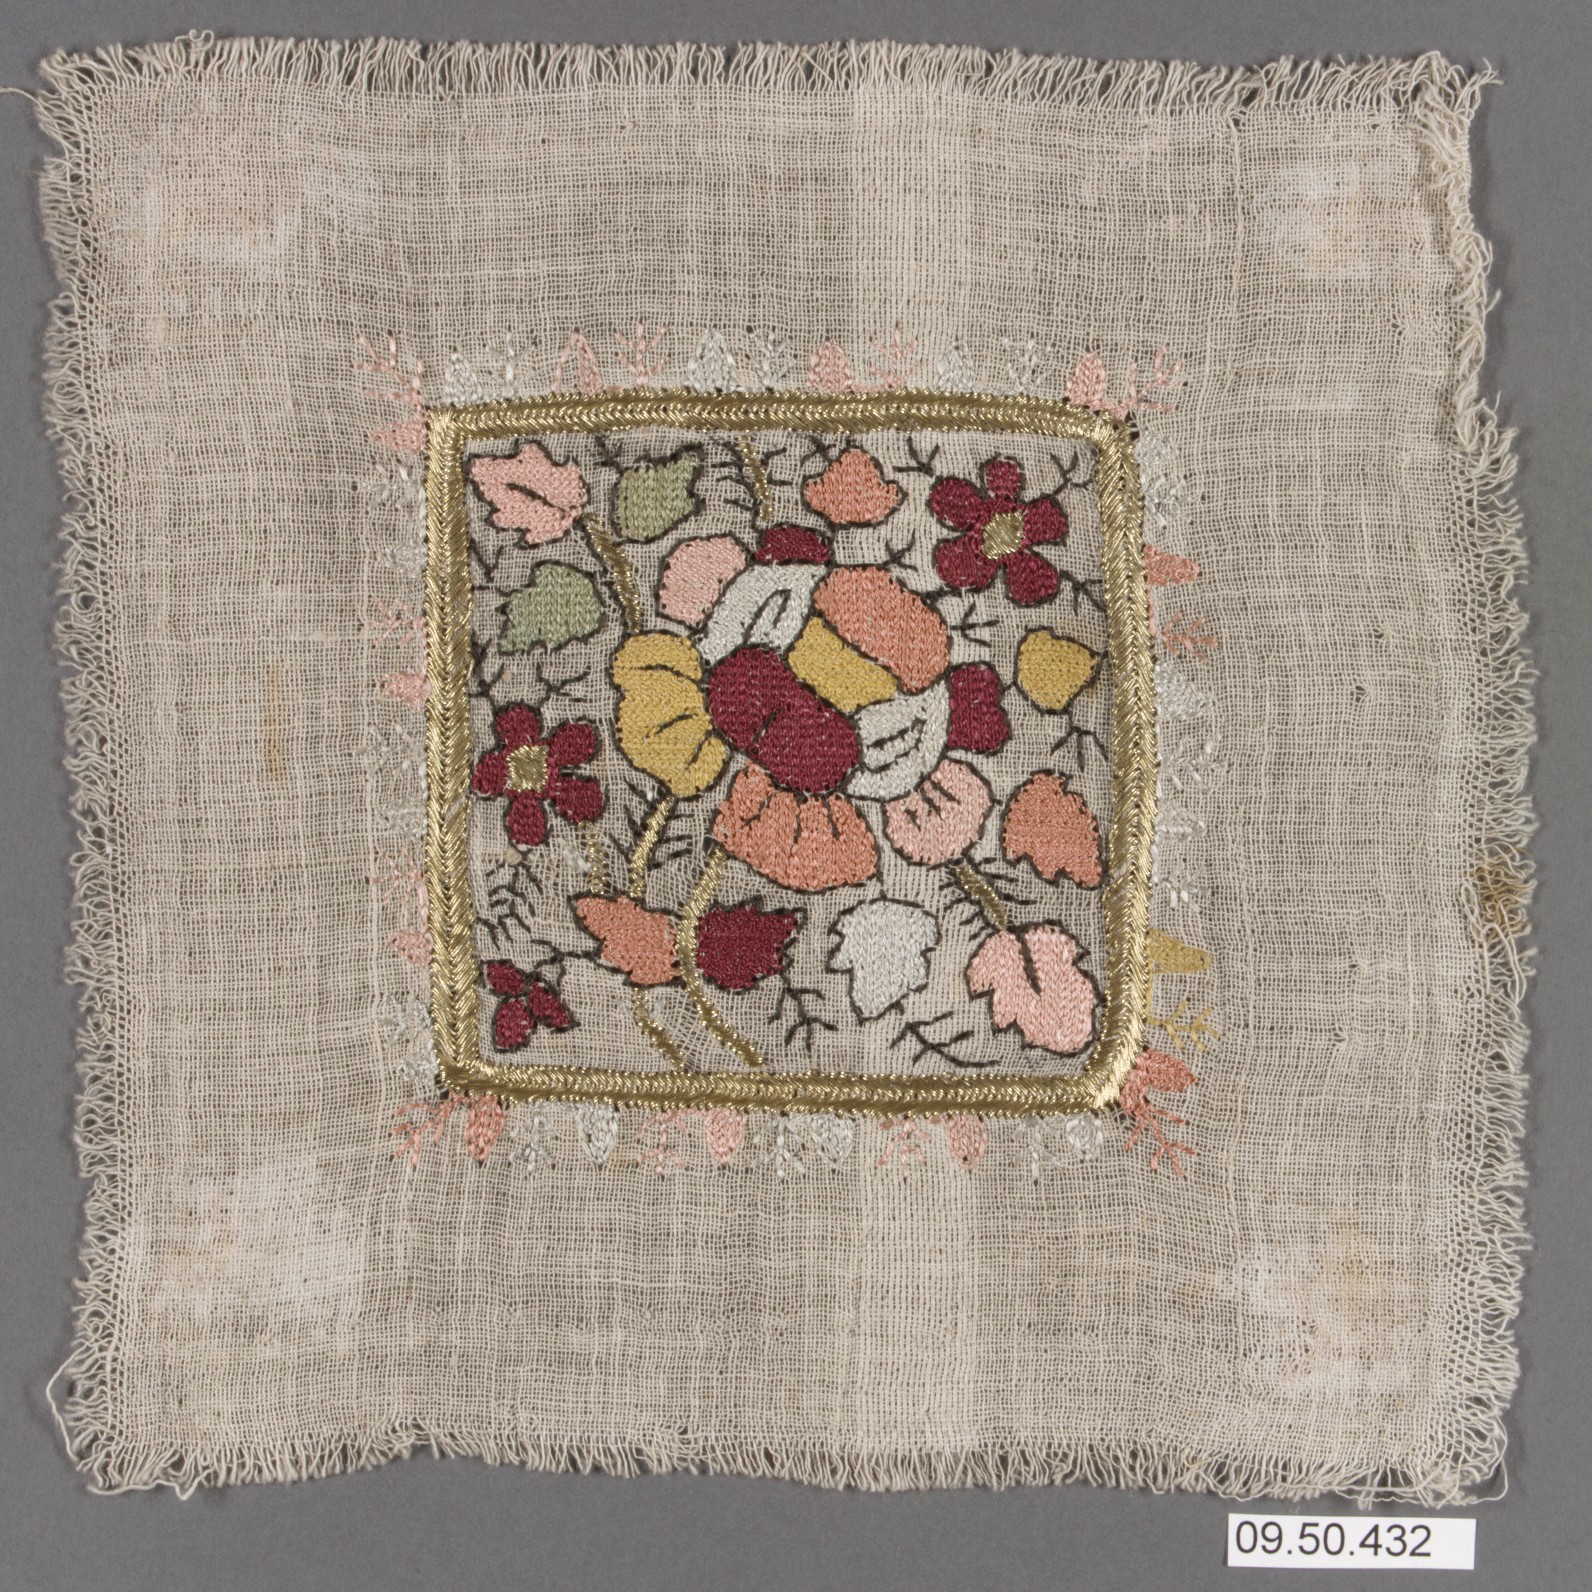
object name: square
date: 1801-1900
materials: cotton, metal thread, silk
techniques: embroidery, weave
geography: turkey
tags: flowers